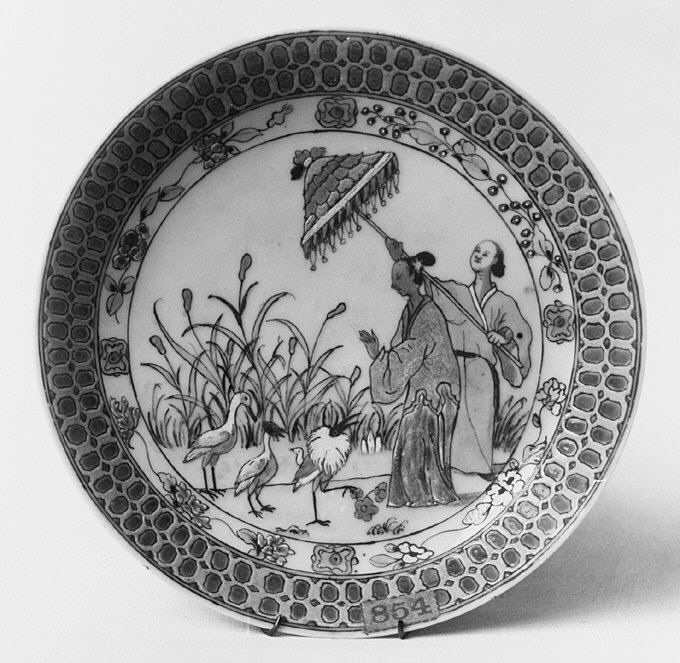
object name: saucer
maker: cornelis pronk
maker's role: artist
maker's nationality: dutch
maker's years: 1691-1759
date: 1736-1738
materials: hard paste porcelain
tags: birds,women